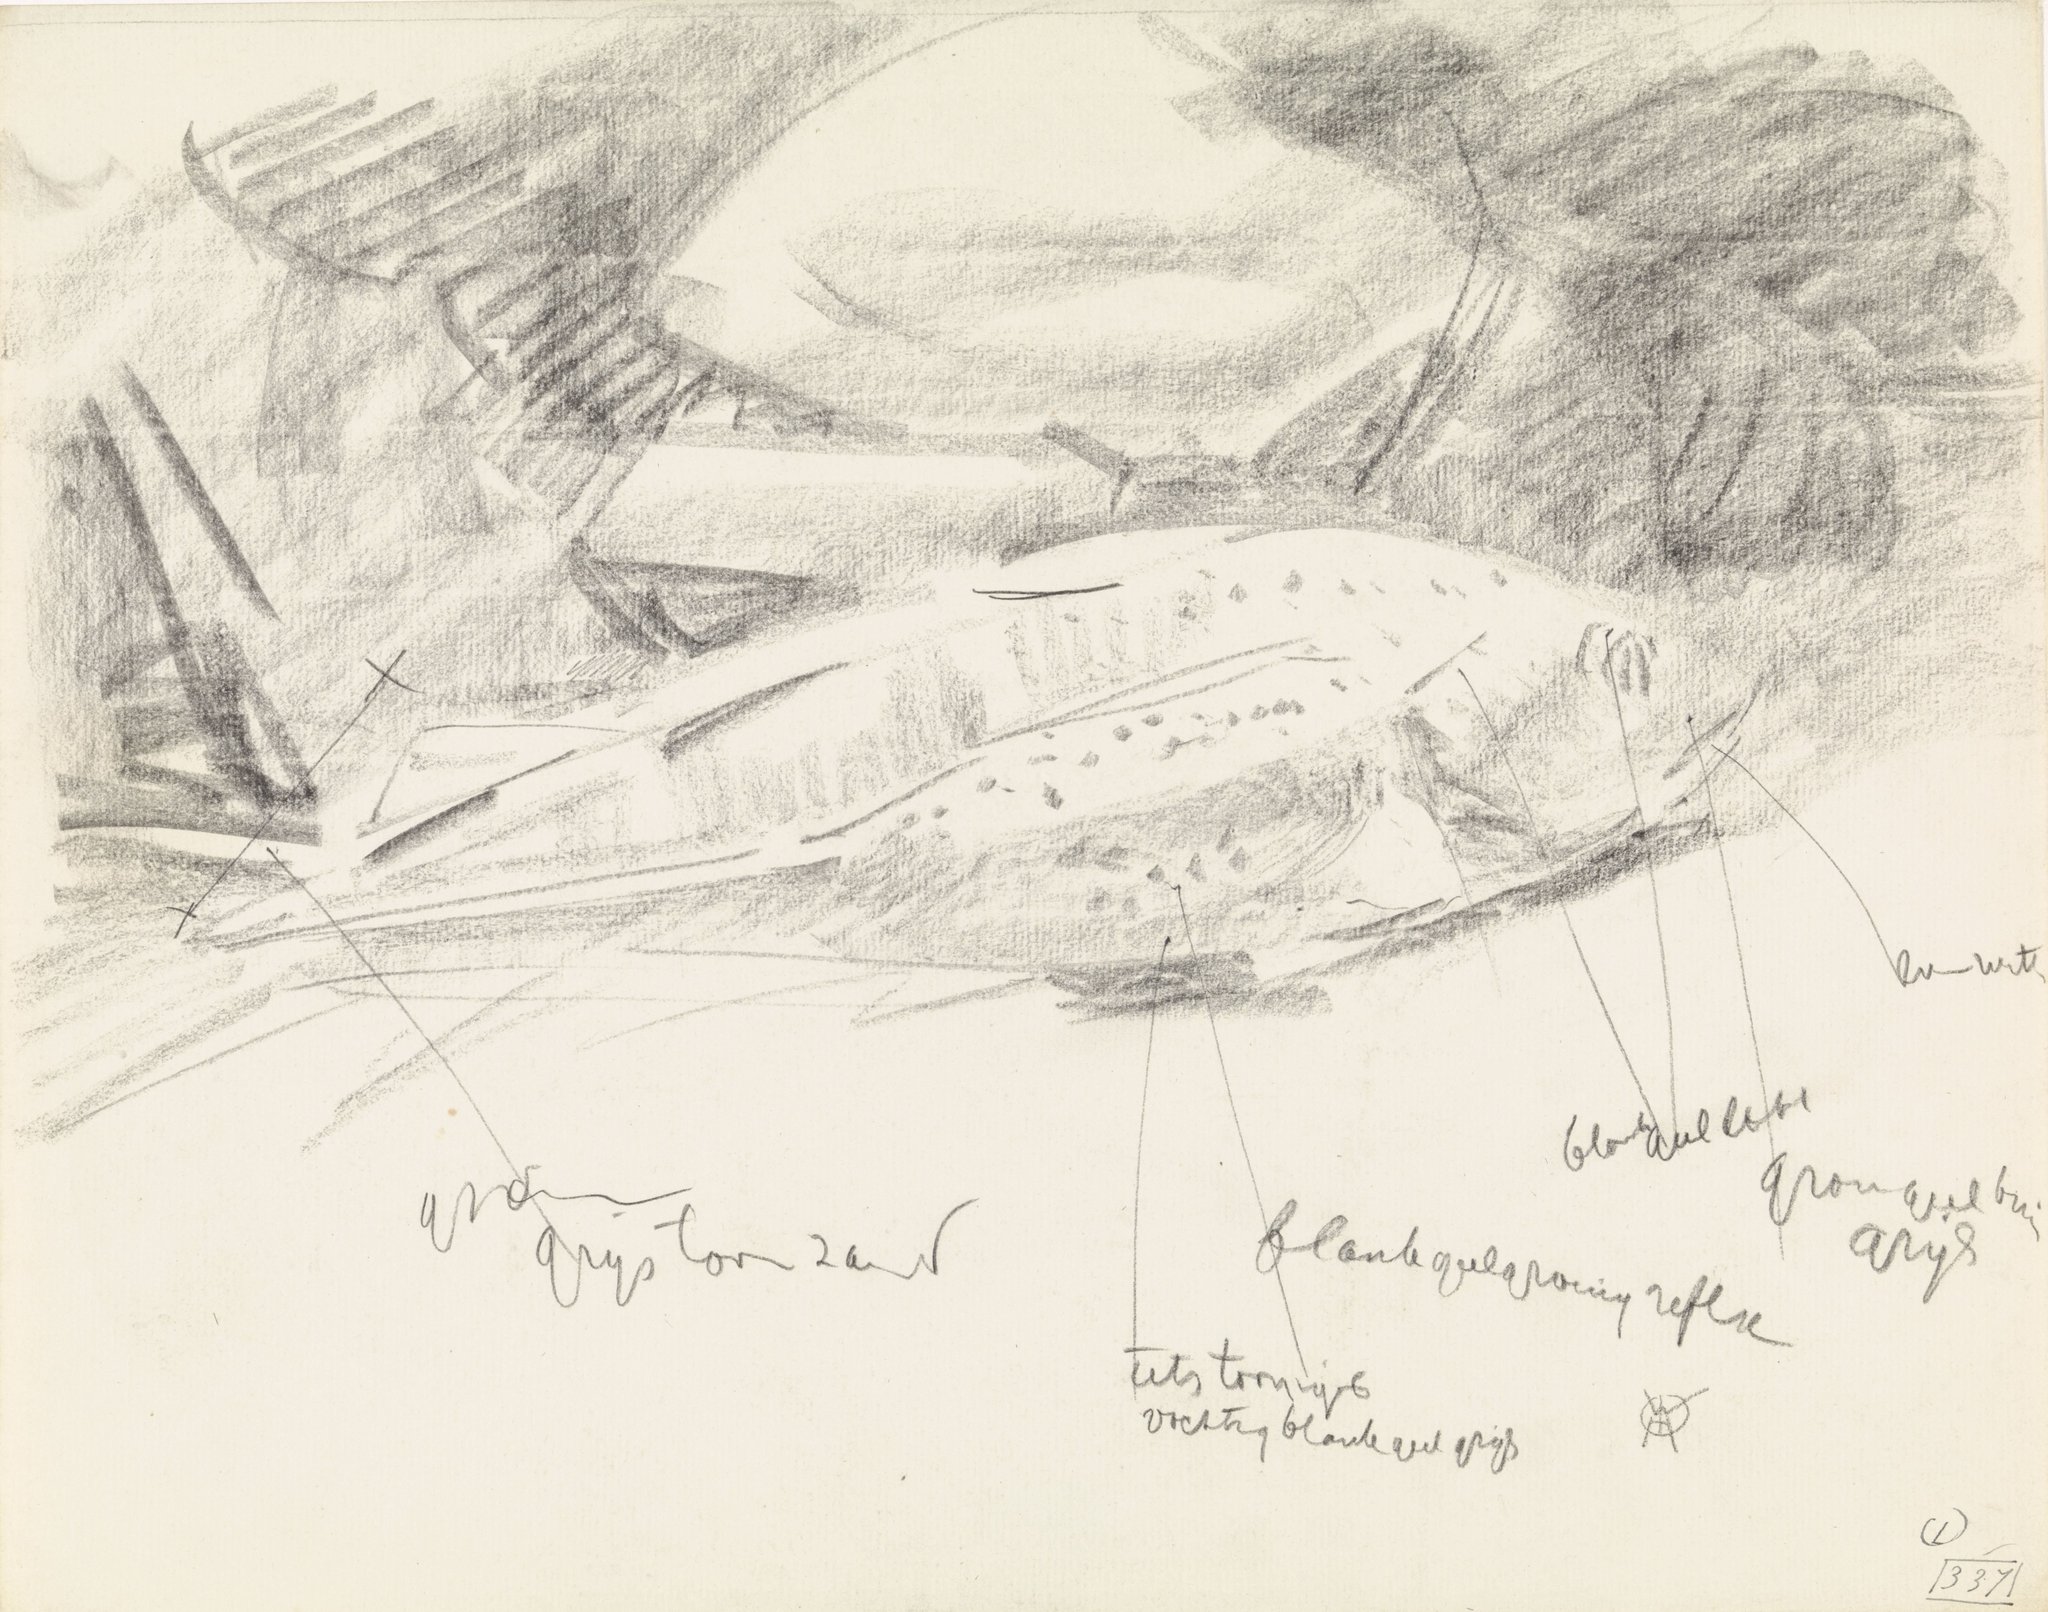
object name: drawing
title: Studies van een vis, met kleurnotities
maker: gerrit willem dijsselhof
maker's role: designer, draughtsman, print maker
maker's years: 1866-1924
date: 1876-1924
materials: chalk, paper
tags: bony fishes